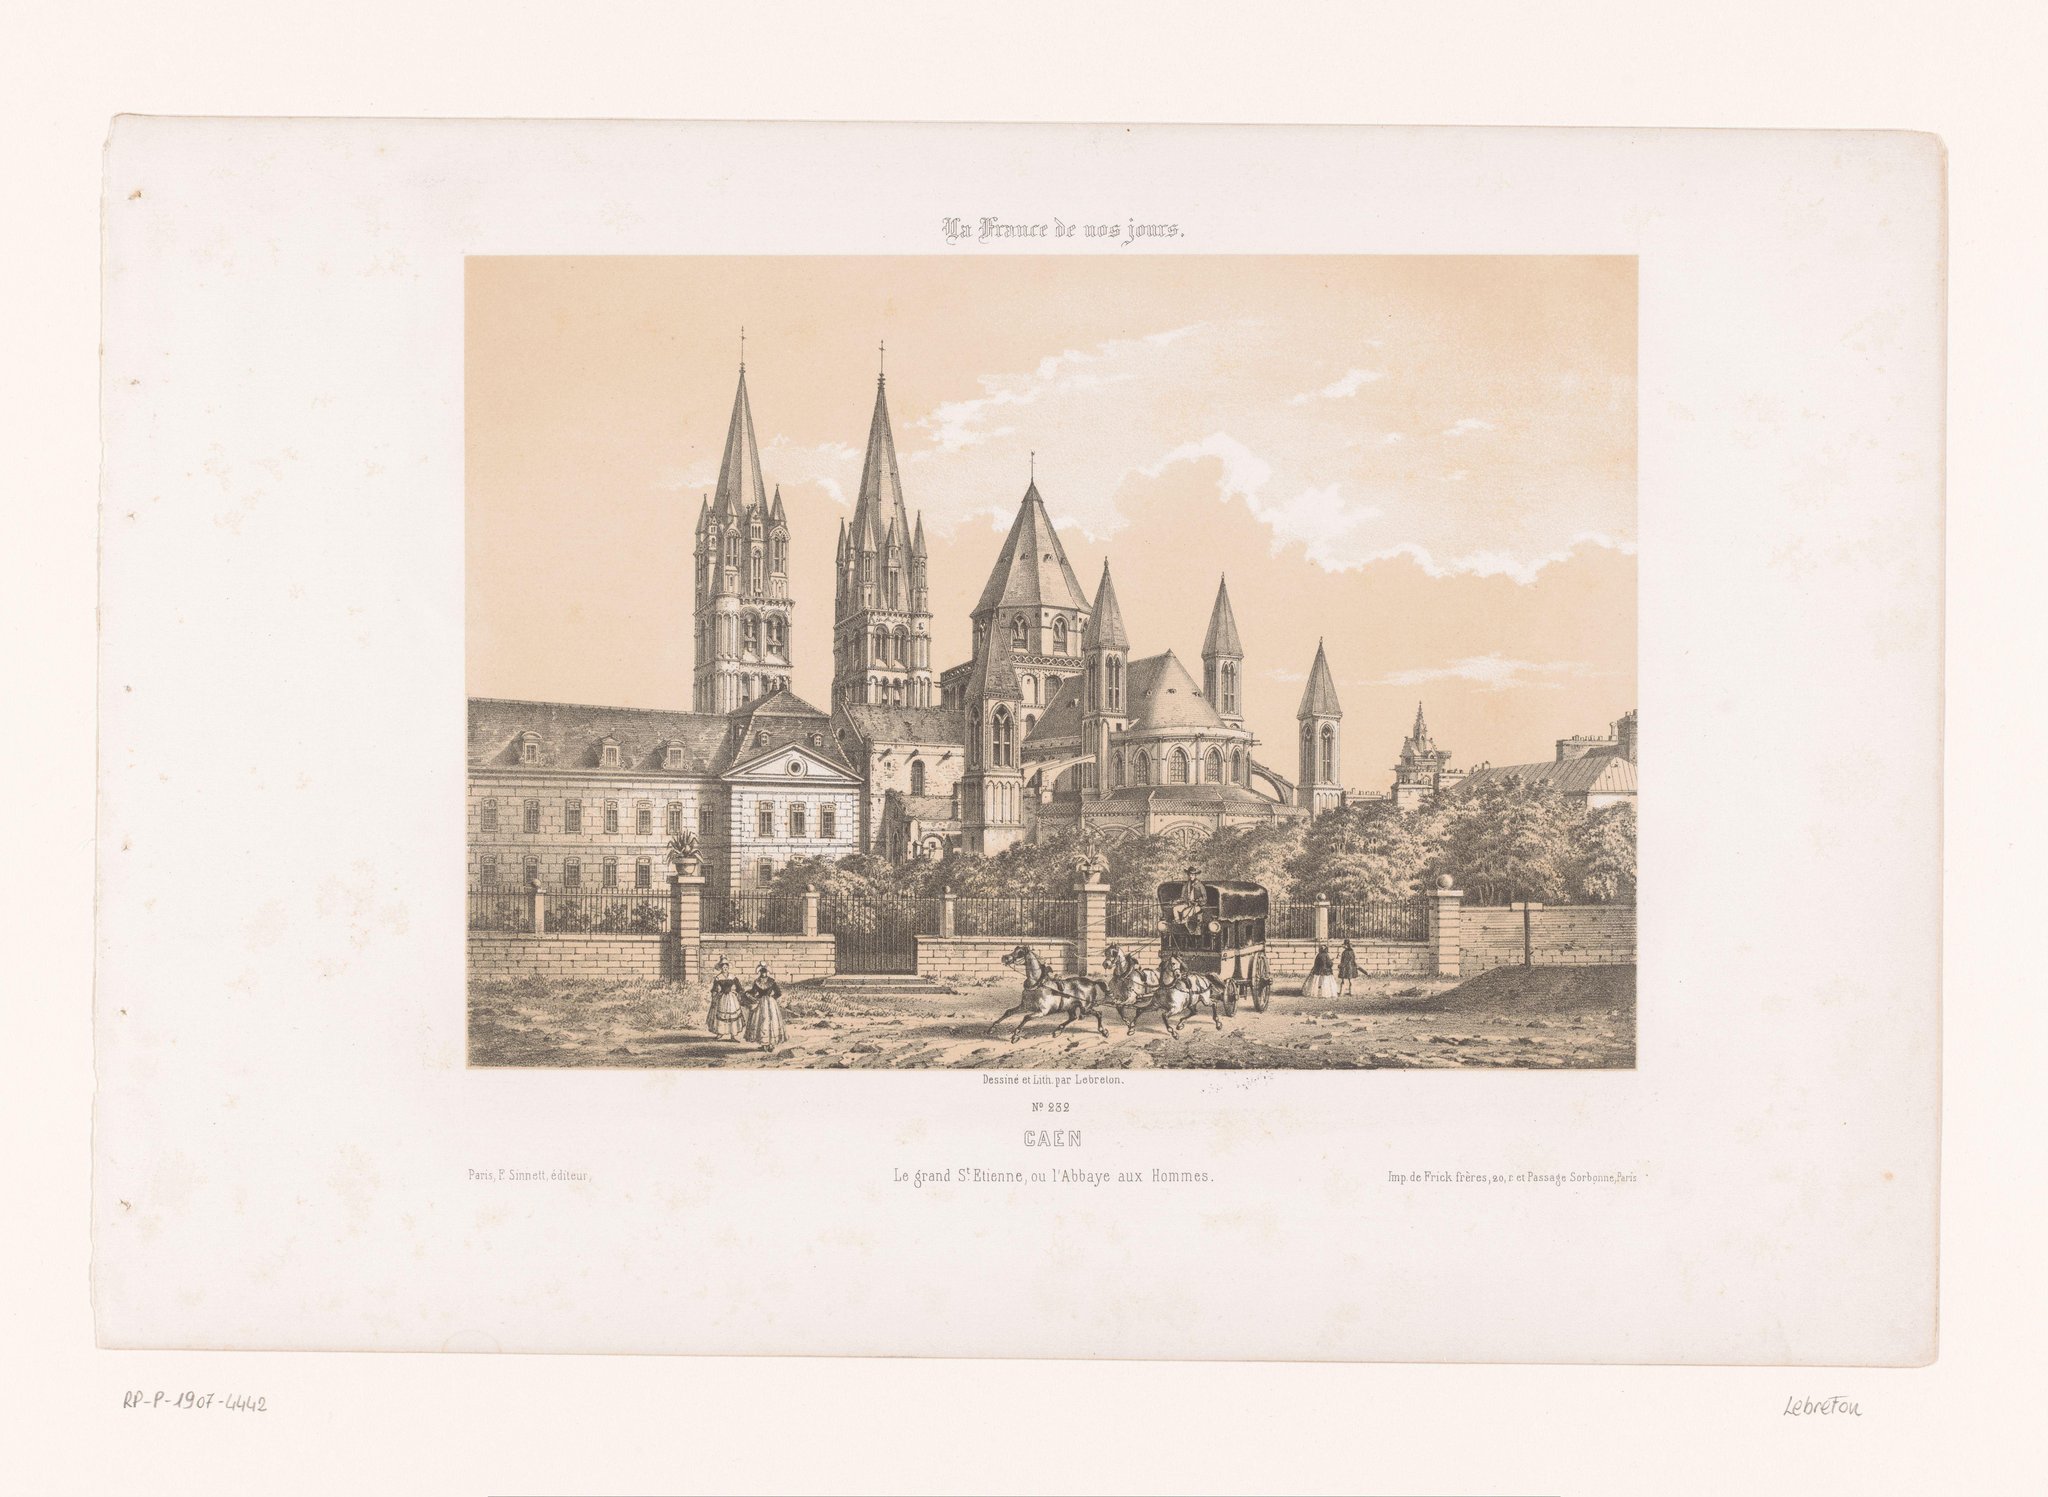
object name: print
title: La France de nos jours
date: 1855-1859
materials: paper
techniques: tone lithography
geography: paris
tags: abbey, monastery, convent ~ roman catholic church, church (exterior)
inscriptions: collector's mark: Lugt 2228a